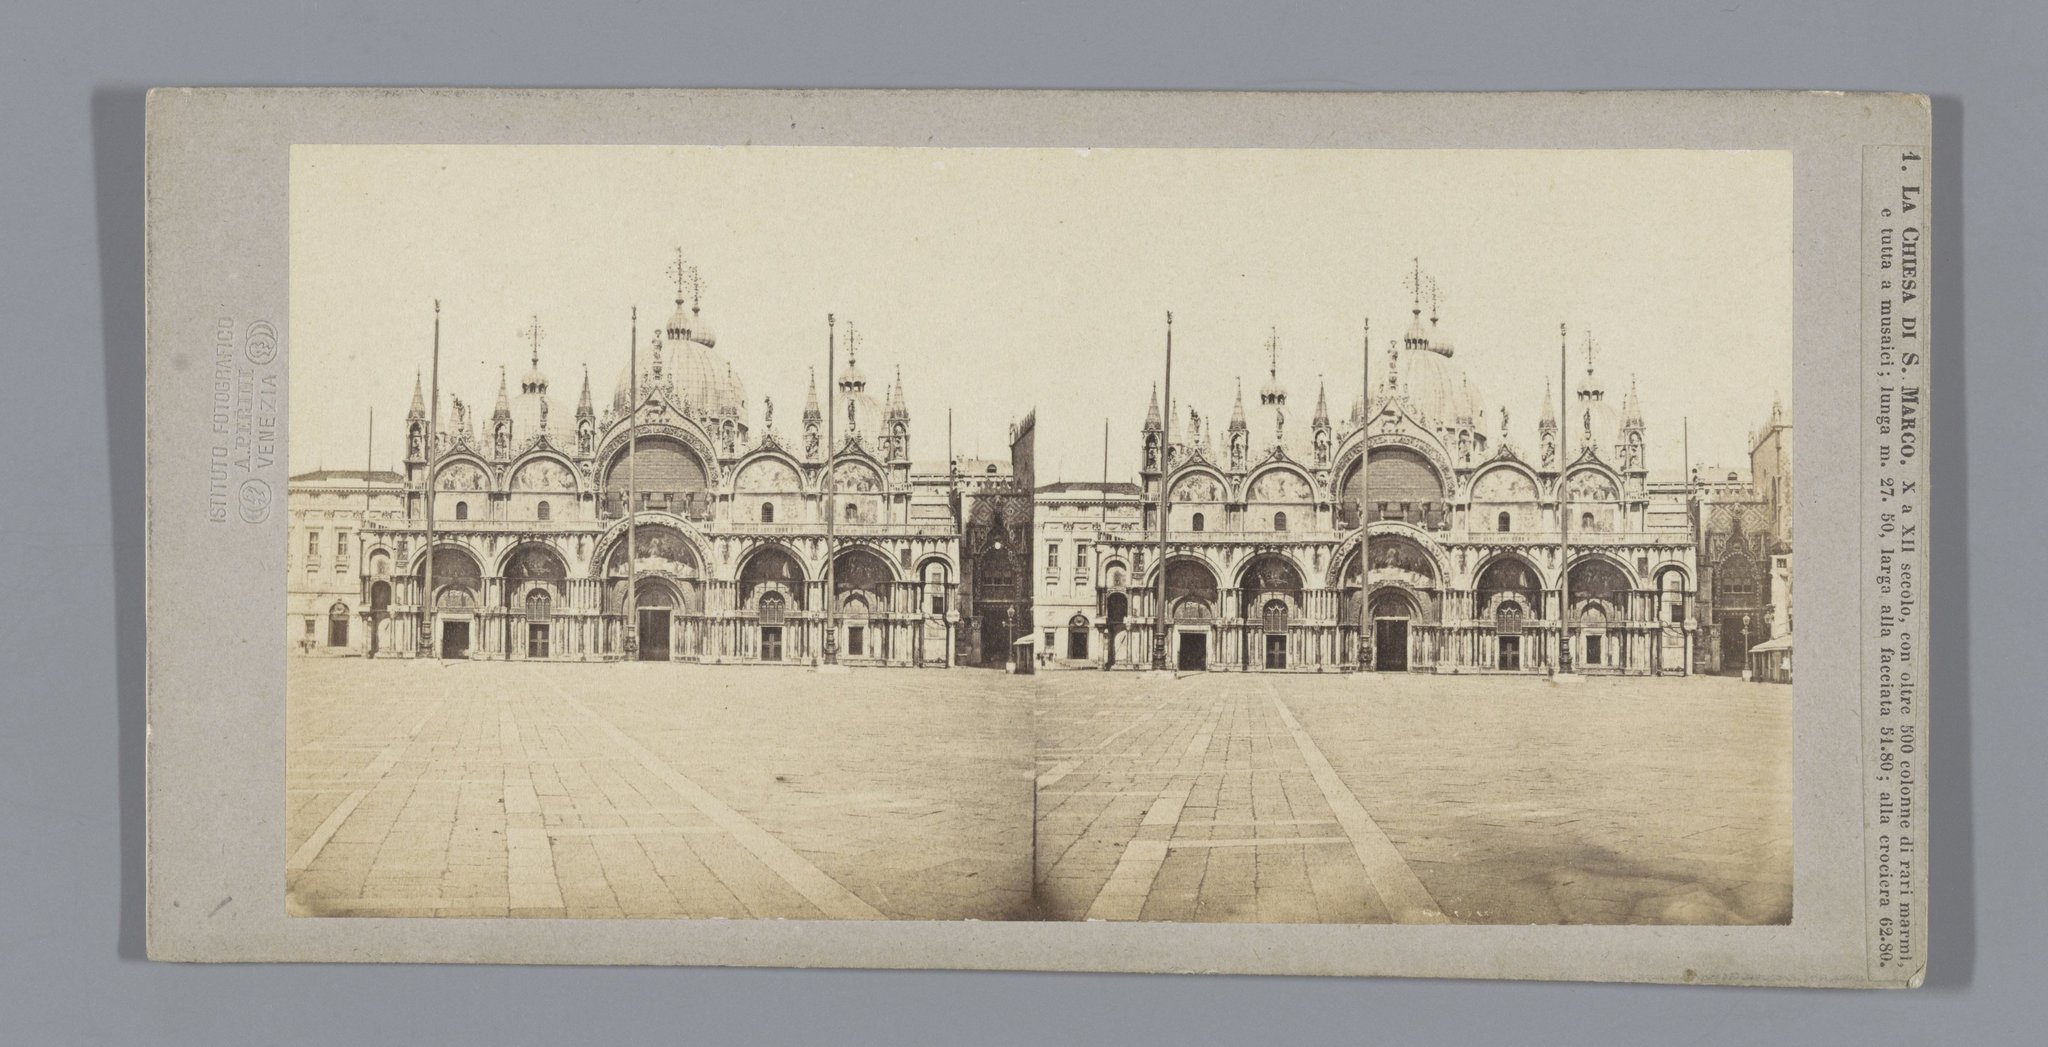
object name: stereograph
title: Voorgevel van de Basiliek van San Marco te Venetië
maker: antonio perini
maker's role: fotograaf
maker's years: 1830-1879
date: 1850-1870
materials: cardboard, photographic support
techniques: albumen print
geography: san marco square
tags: façade (of house or building)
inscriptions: name: ‘ISTITUTO FOTOGRAFICO A.PERINI VENEZIA’, number: ‘1.’, inscription: ‘X a XII secolo (...) alla crociera 62.80.’